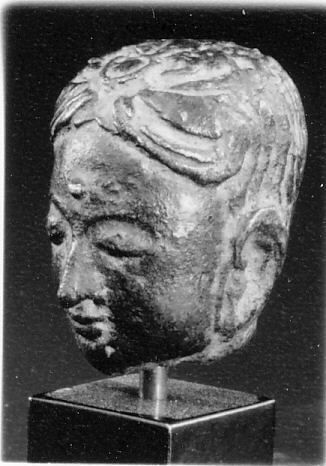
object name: head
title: Male Head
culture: indonesian, javanese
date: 1101-1400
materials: bronze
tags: heads,men